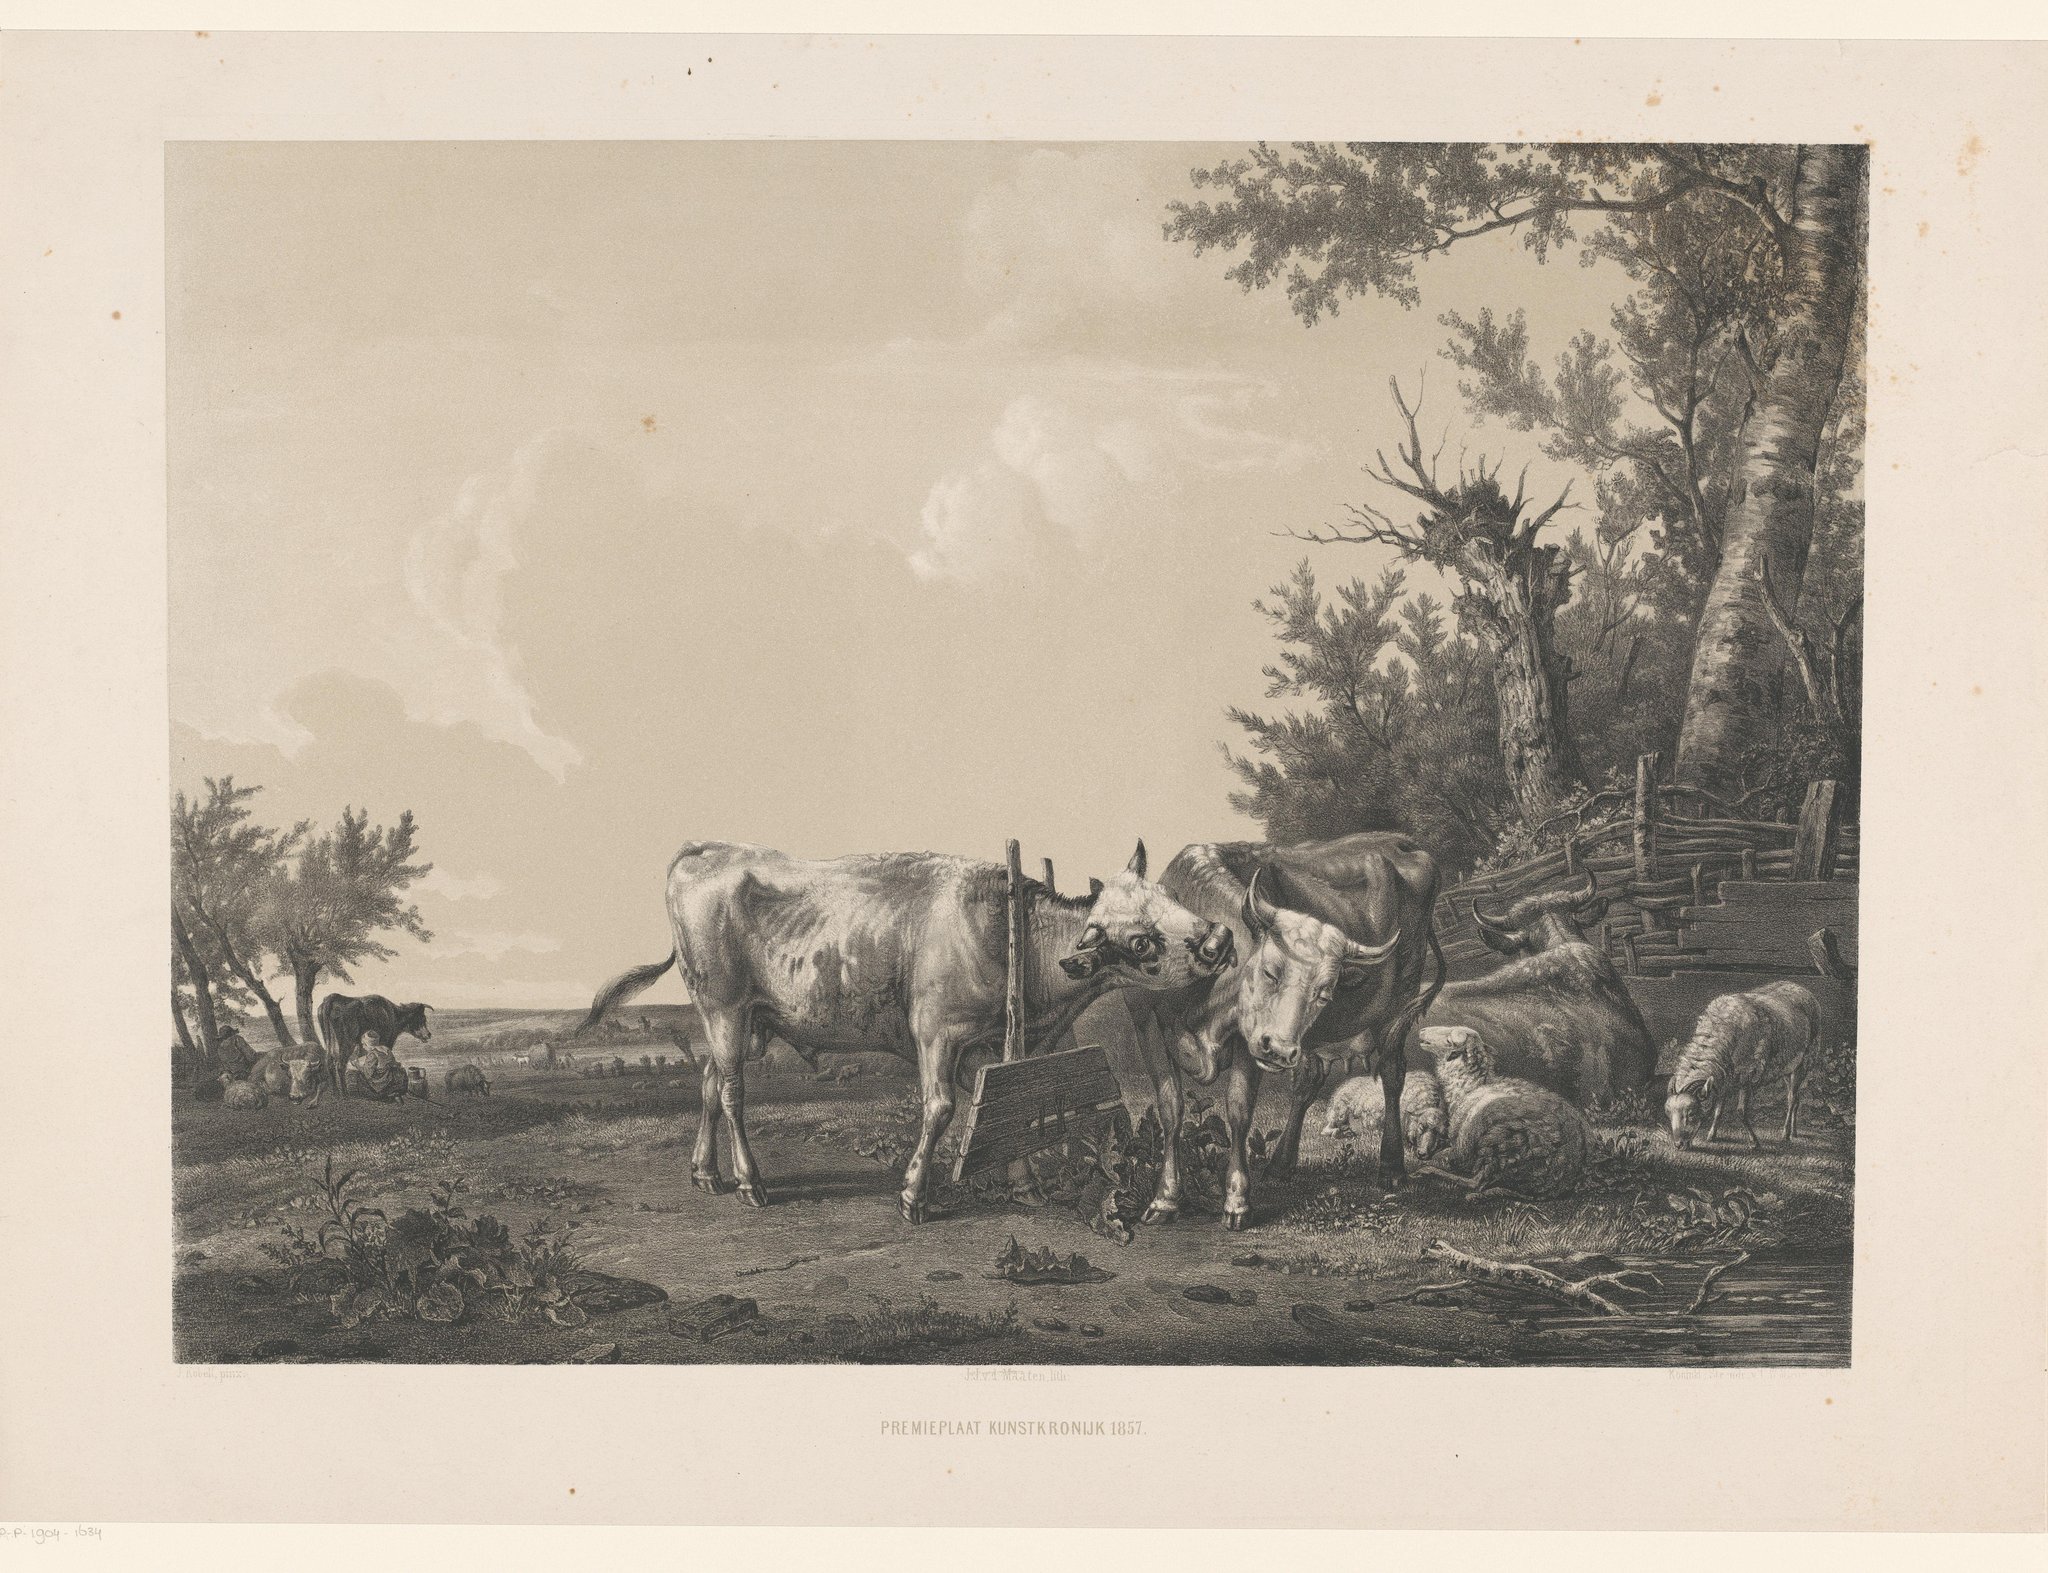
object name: print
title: Twee koeien en vee in landschap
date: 1857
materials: paper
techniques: tone lithography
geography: the hague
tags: cow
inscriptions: collector's mark: Lugt 2228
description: Twee koeien op de voorgrond, waarvan er één een dwanghalster om heeft. Achter hen liggende schapen en een liggende koe. Links op de achtergrond een man en vrouw met een ander deel van de kudde. Premieplaat bij Kunstkronijk 1857.